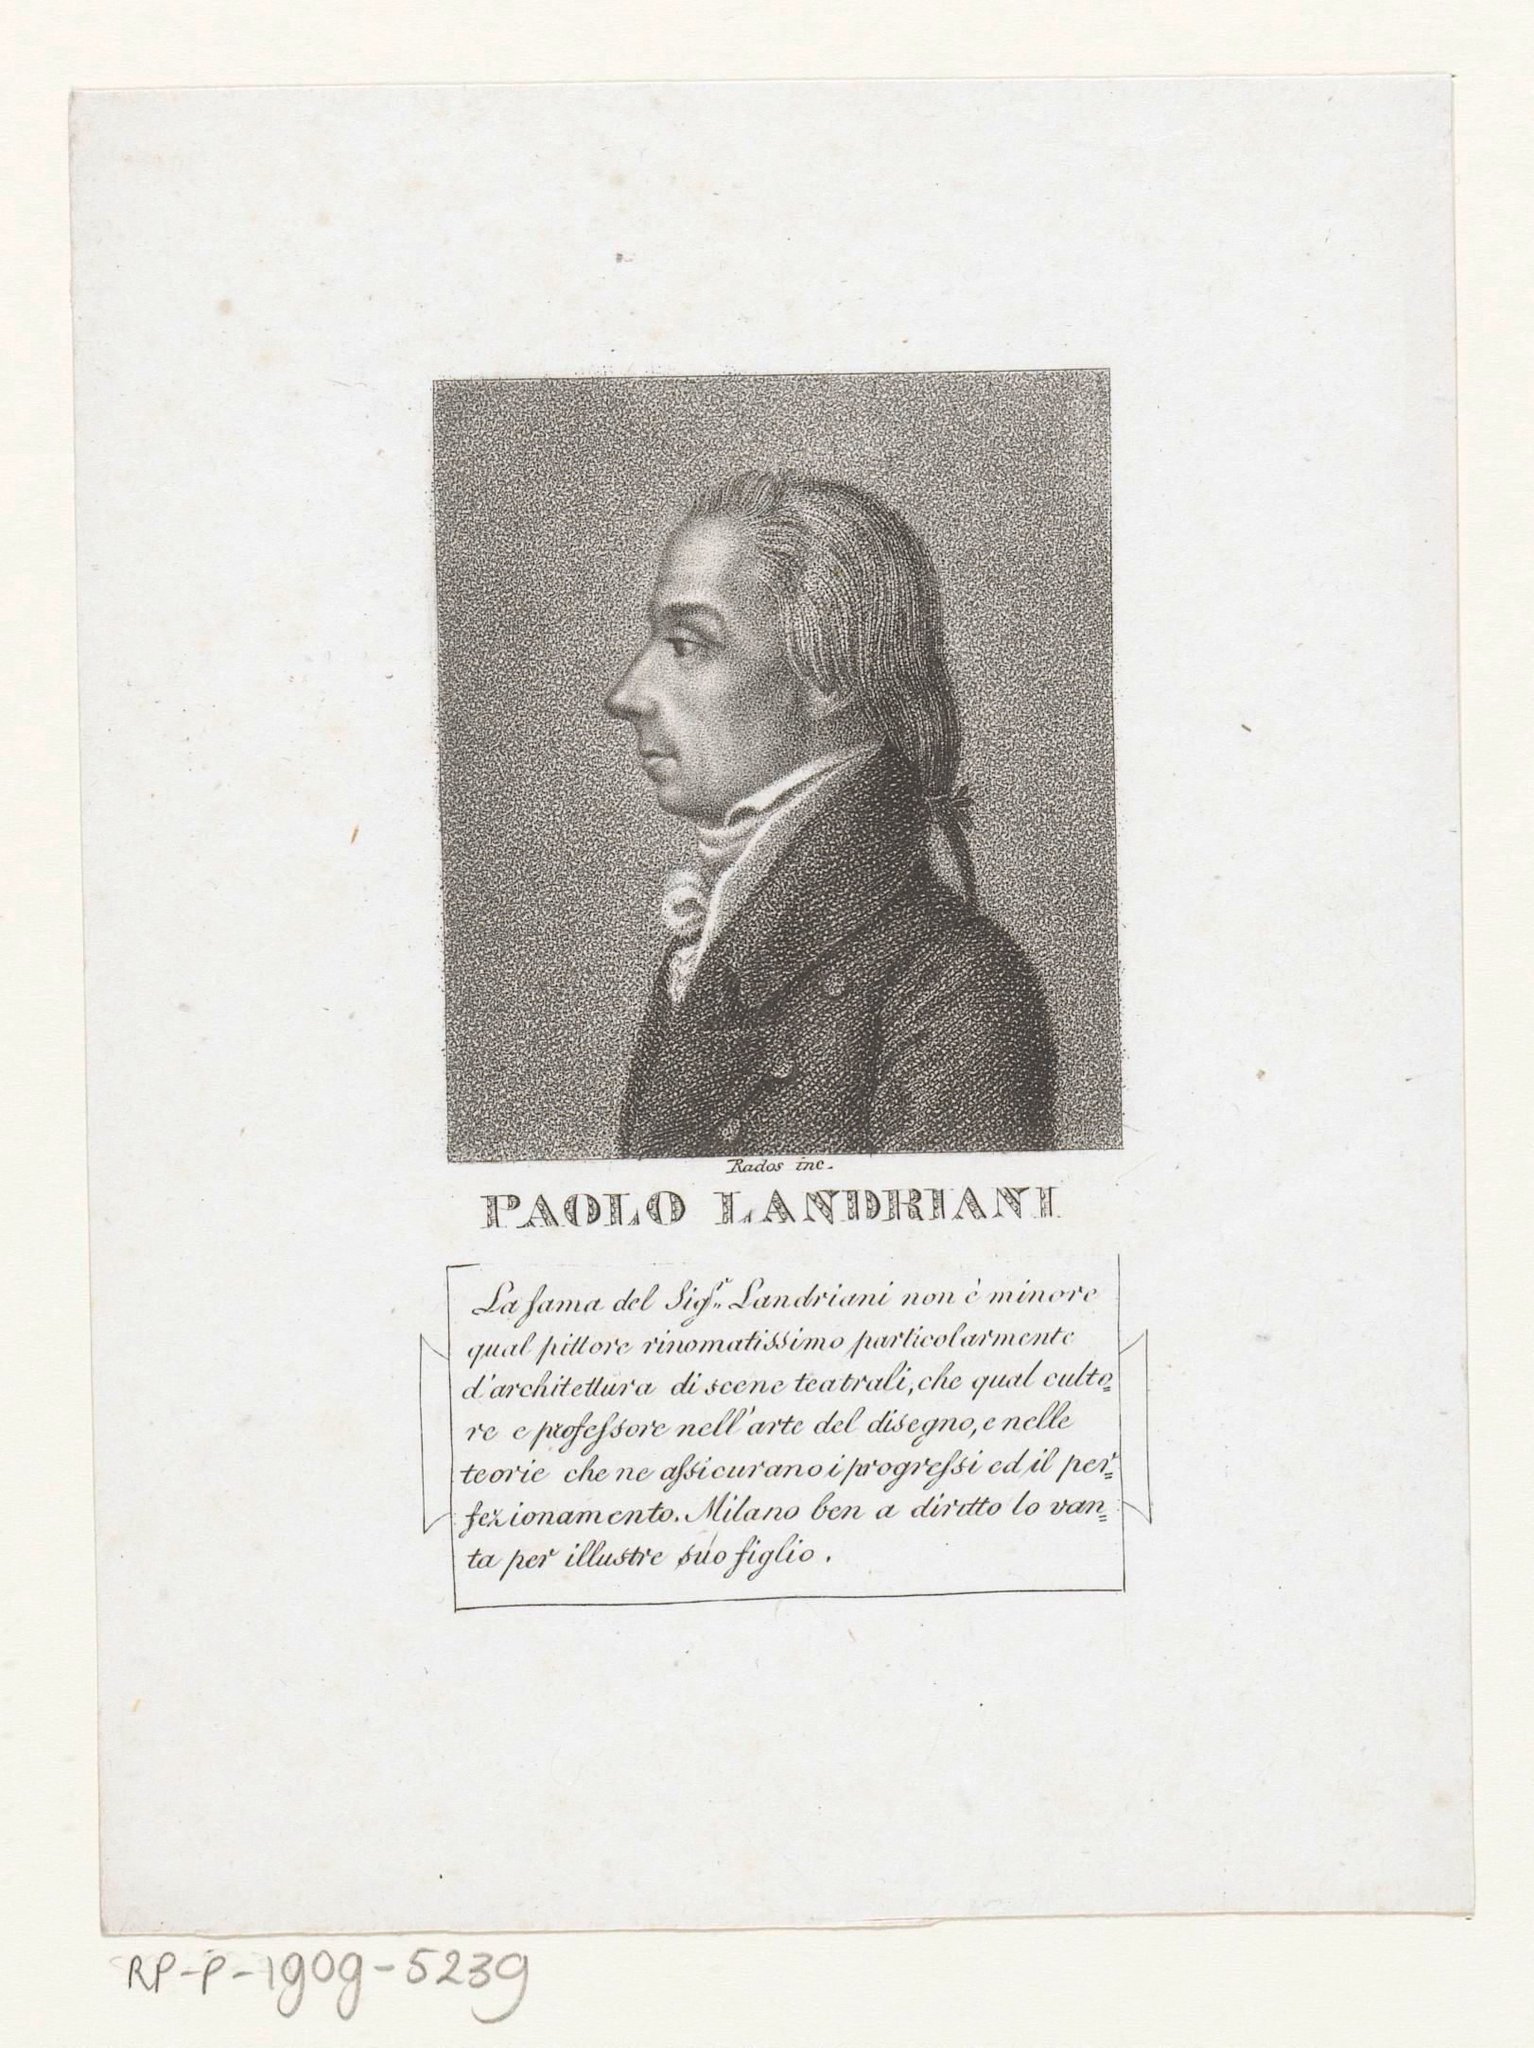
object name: print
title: Portret van architect Paolo Landriani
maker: luigi rados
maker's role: print maker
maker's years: 1773-1840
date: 1783-1840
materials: paper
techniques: etching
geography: italy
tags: painter, paolo landriani, historical persons, portrait, self-portrait of architect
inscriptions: collector's mark: Lugt 2228